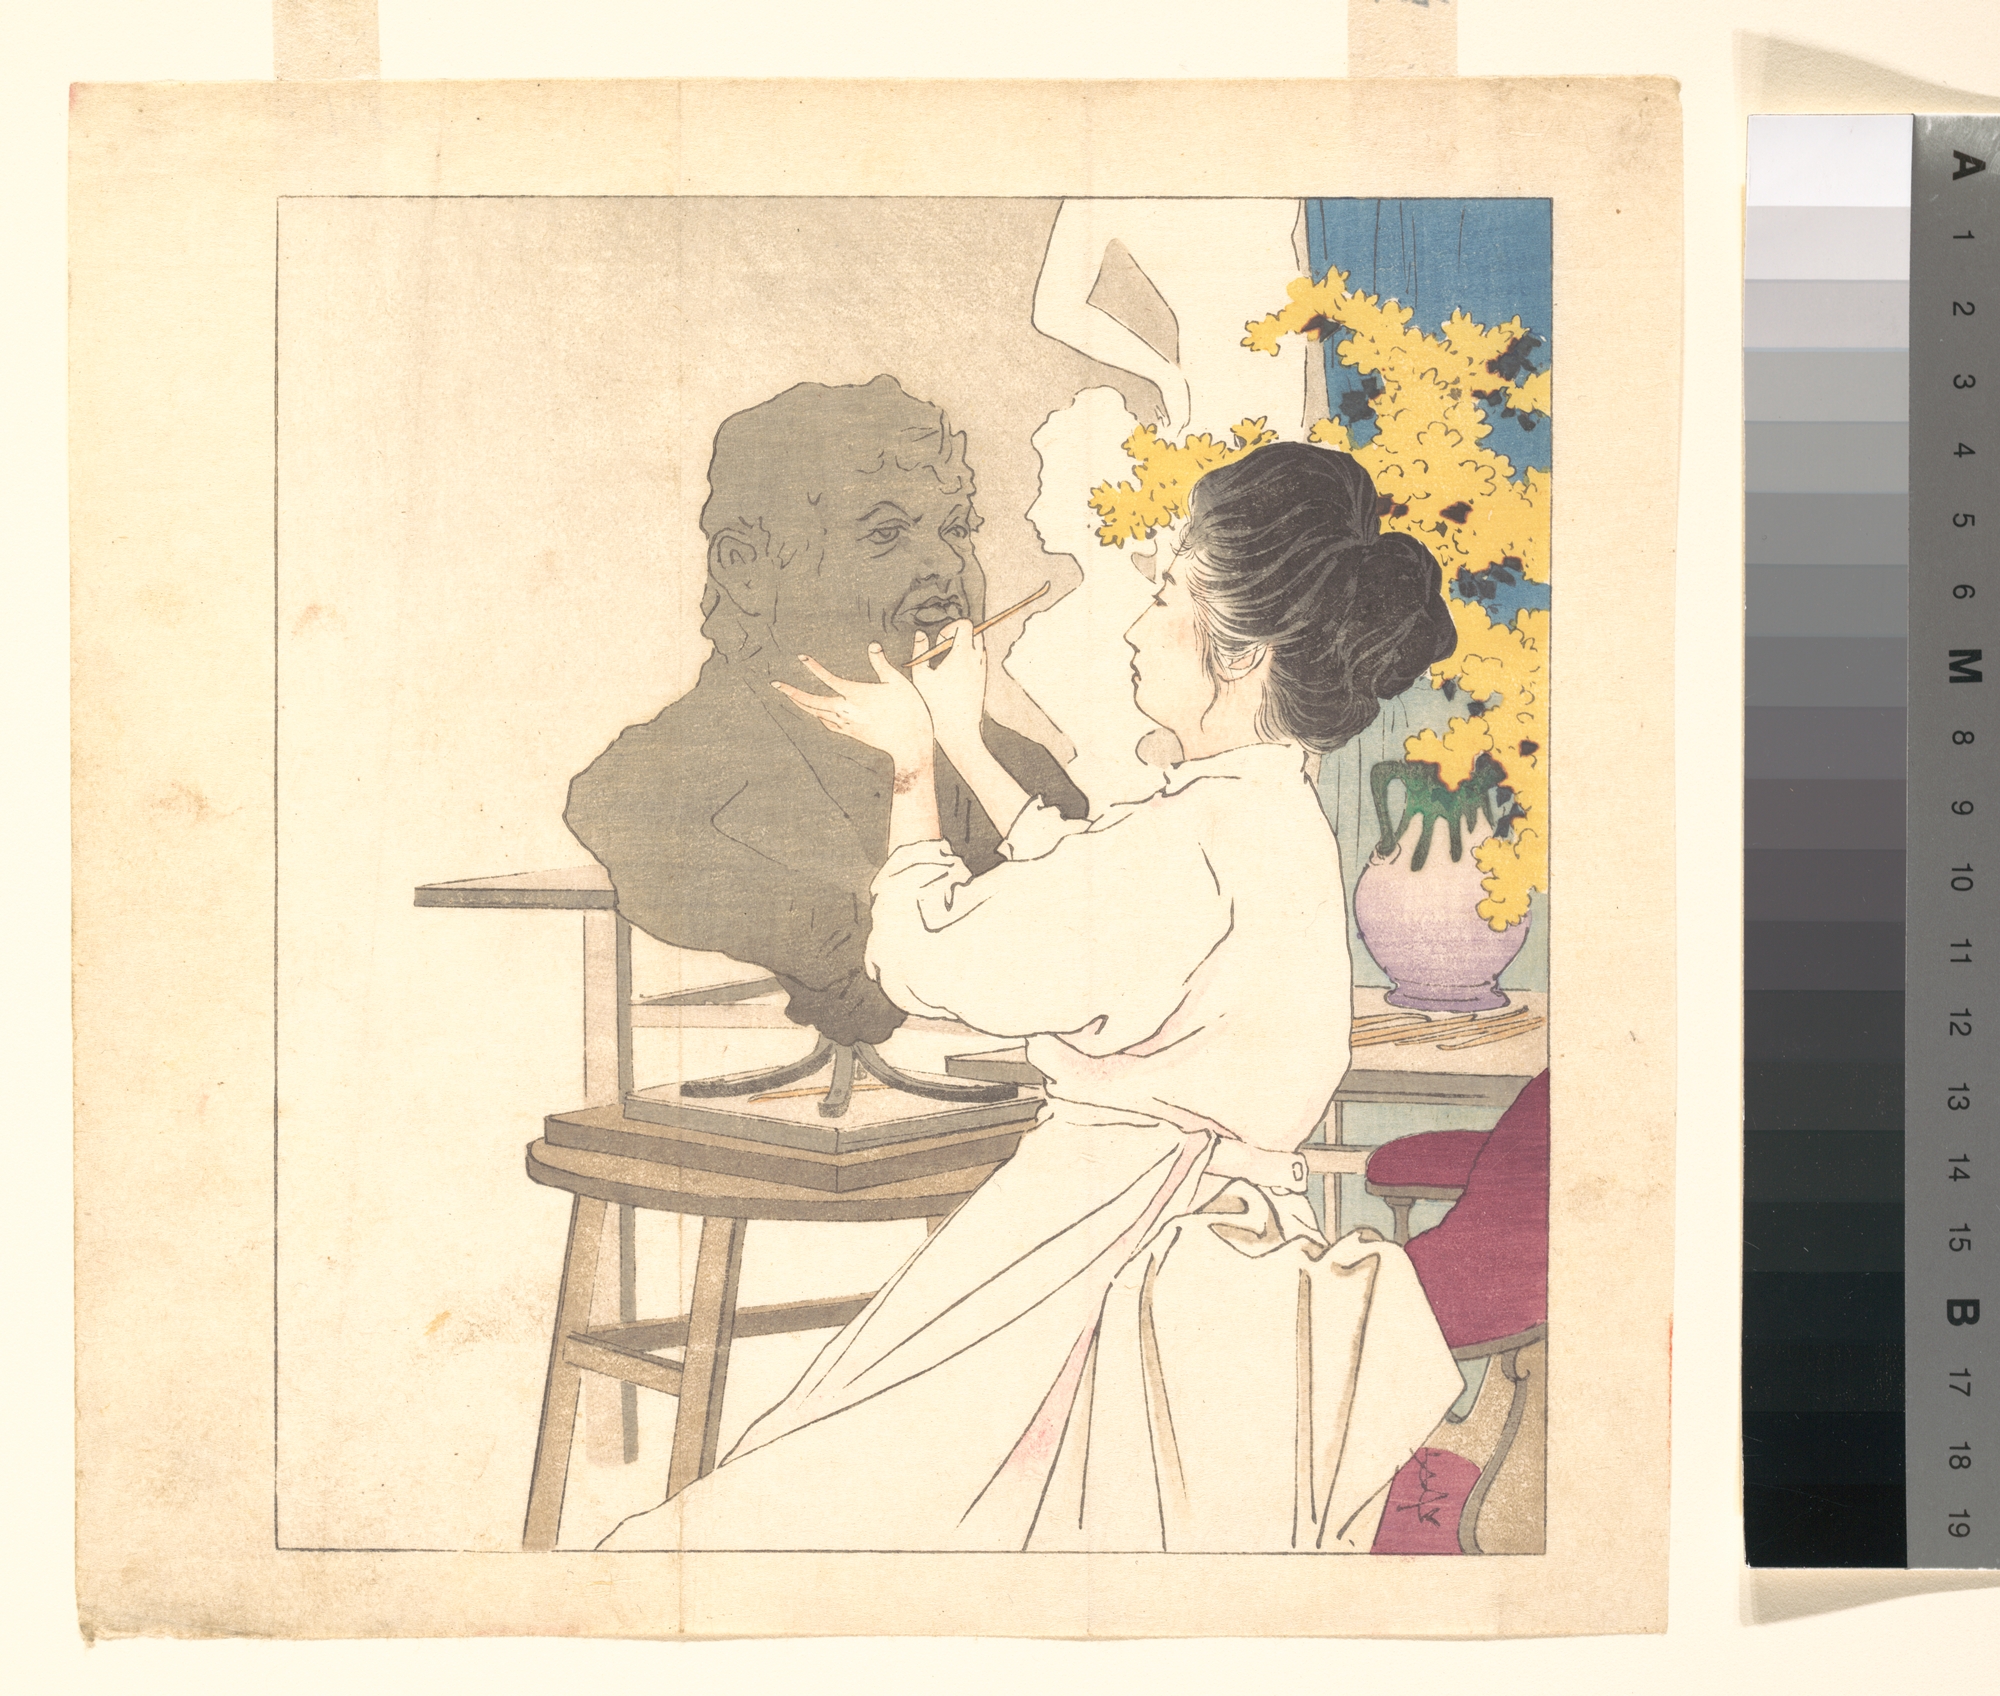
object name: print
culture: japanese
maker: kajita hanko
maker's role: artist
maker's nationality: japanese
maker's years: 1870-1917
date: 1906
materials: ink, paper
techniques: woodblock print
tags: men,women,working